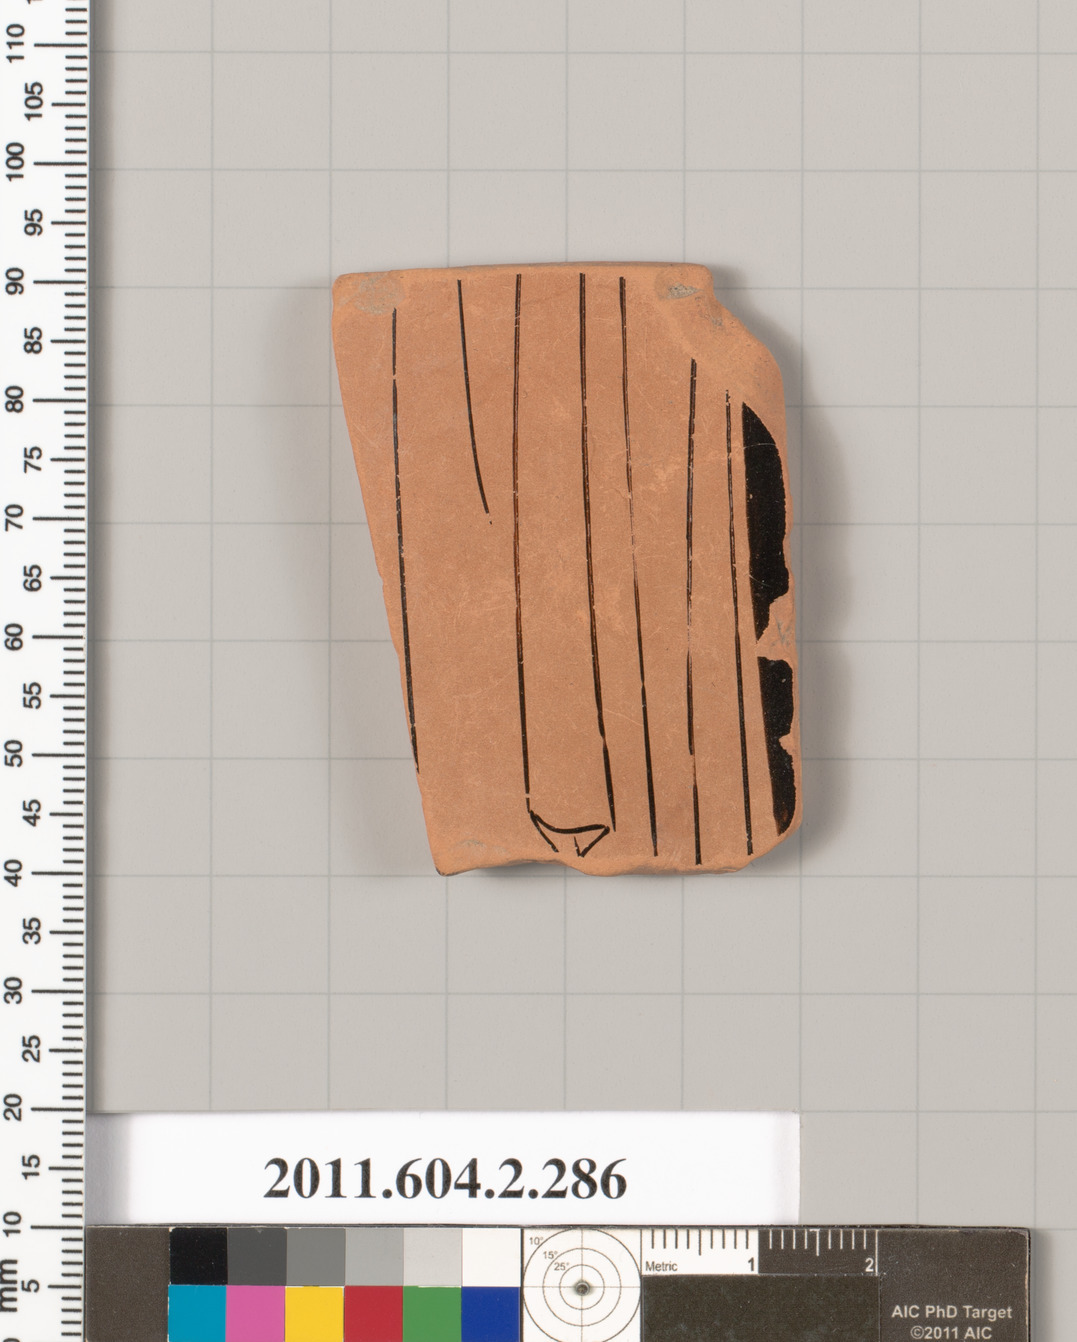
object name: column krater fragment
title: Terracotta fragment of a column-krater? (bowl for mixing wine and water)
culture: greek, attic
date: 475-451 BCE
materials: terracotta